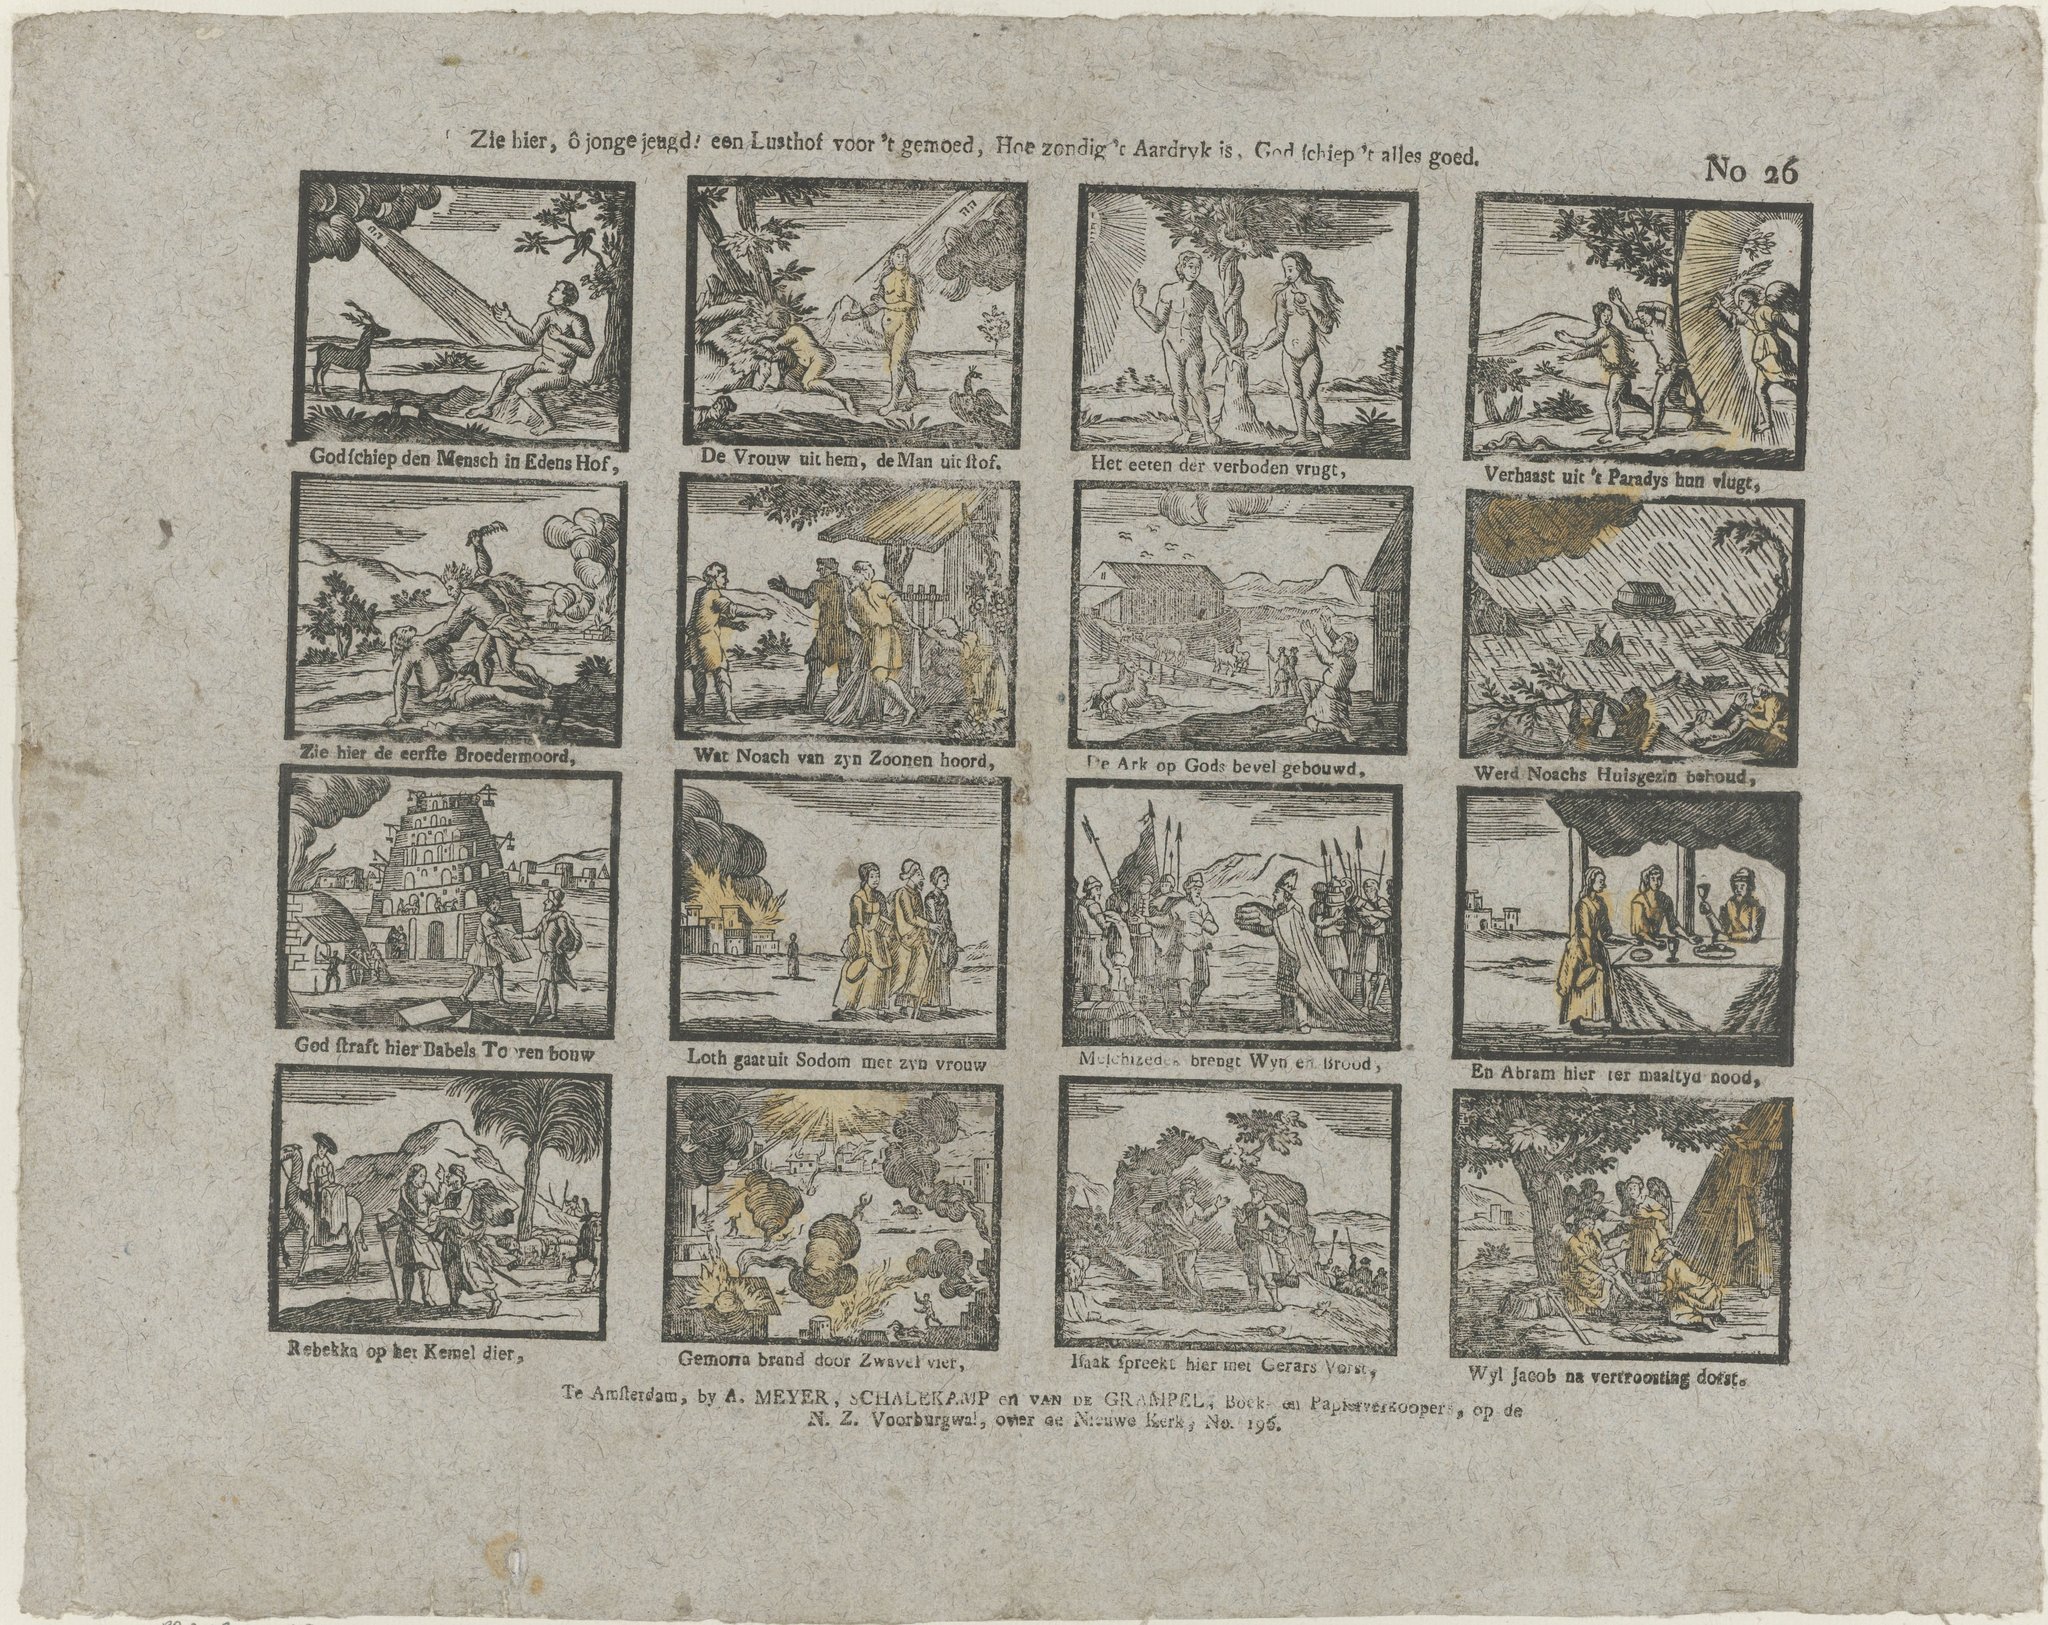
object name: print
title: Zie hier, ô jonge jeugd! des Waerelds eerste stand, / Waarin de boosheid reeds vertoond de overhand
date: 1795-1819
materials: paper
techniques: colour, letterpress printing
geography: amsterdam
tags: abel's death, adam and eve in paradise (before the fall), lot and his daughters (genesis 19:30-38), the tower of babel, expulsion of adam and eve from paradise (genesis 3:22-24), story of noah, old testament, temptation and fall: adam and eve in paradise (after the fall) (genesis 3:8-21)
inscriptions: collector's mark: Lugt 2760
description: Blad met 16 voorstellingen van verhalen uit het Oude Testament, zoals de dood van Abel en het vertrek van Lot met zijn familie uit Sodom. Onder elke afbeelding een tweeregelig vers en een verwijzing naar de bijbehorende Bijbeltekst. Genummerd rechtsboven: No. 26.